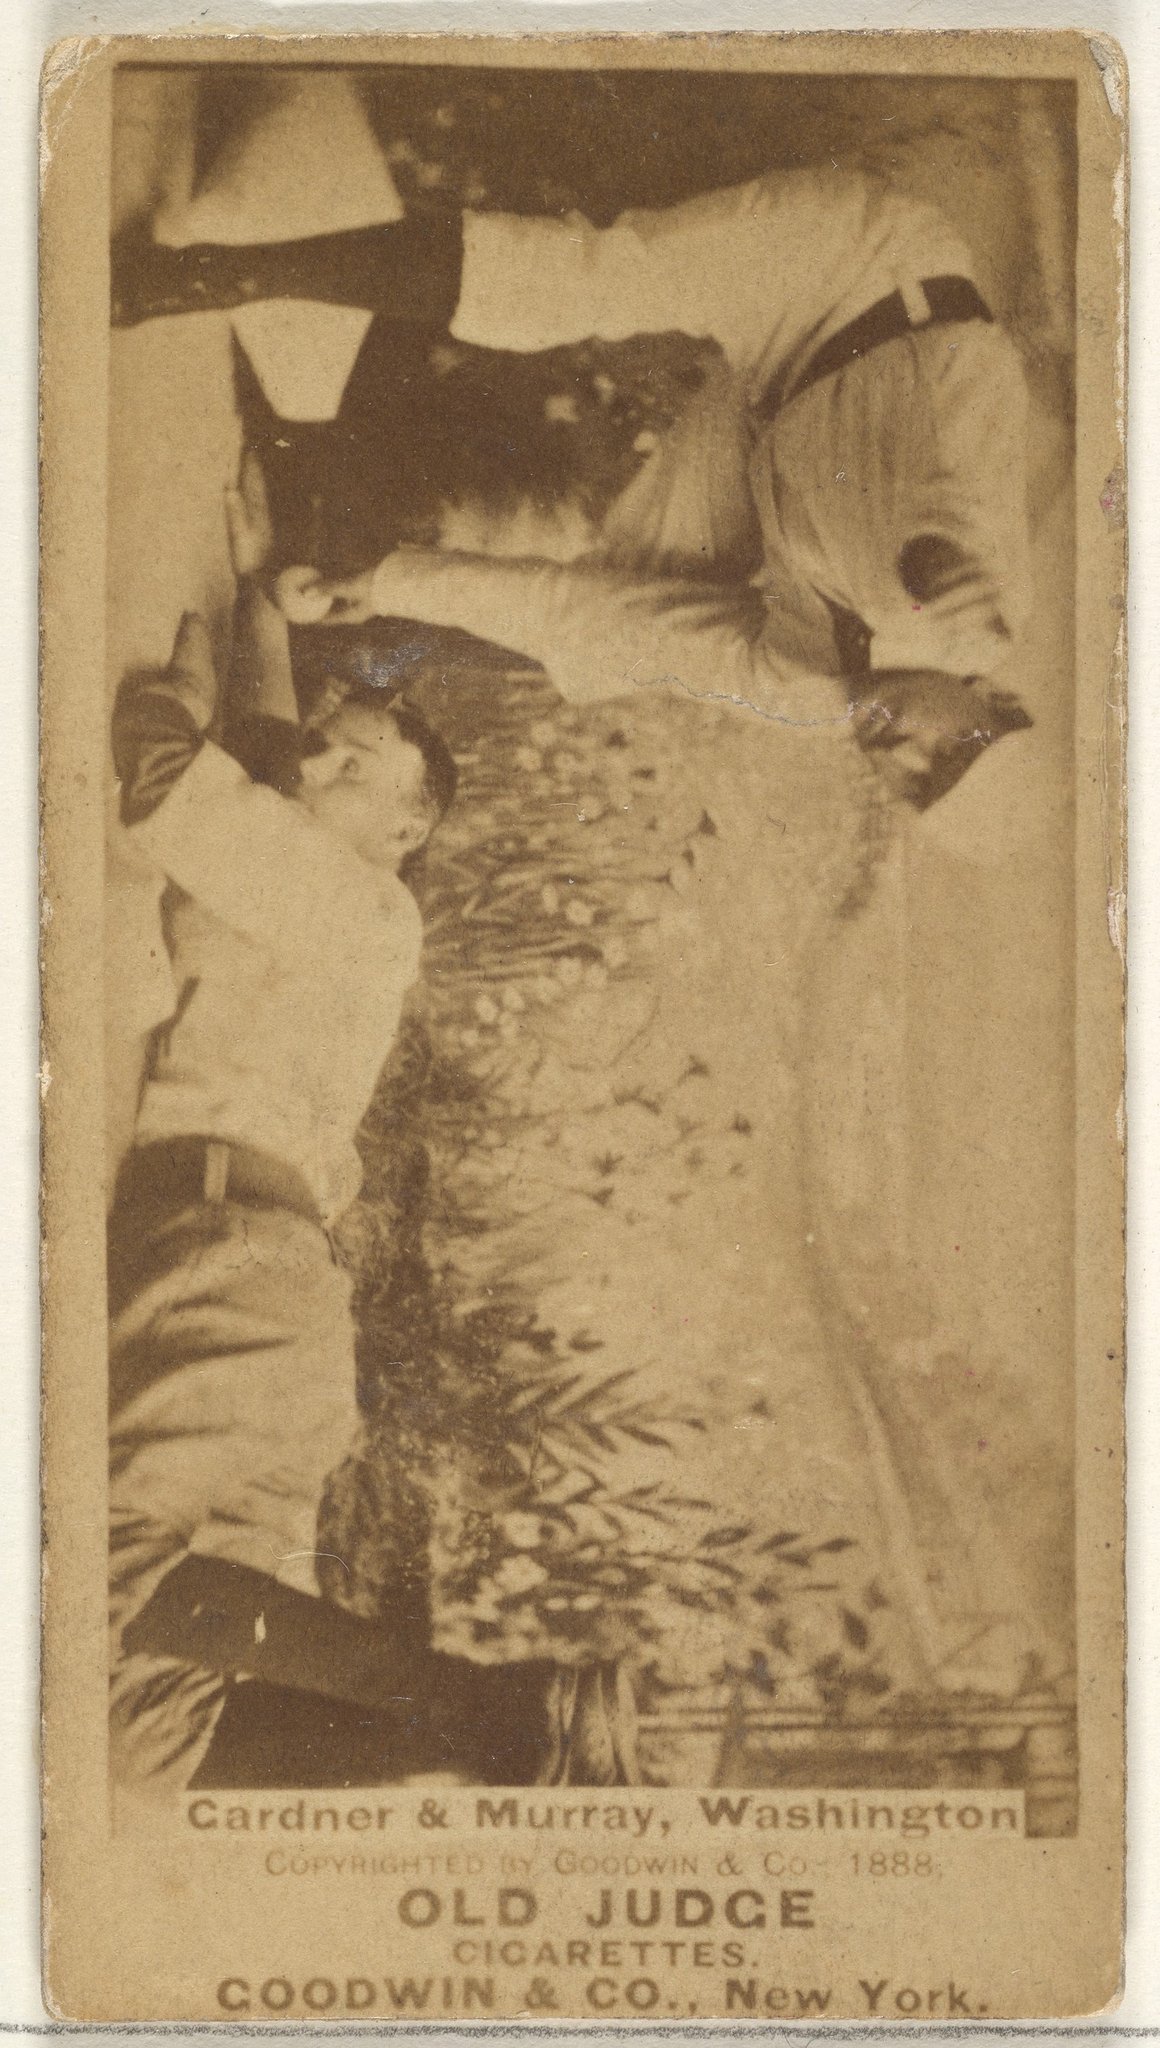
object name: baseball card, photograph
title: Franklin Washington "Gid" Gardner and Jeremiah J. "Miah" Murray, Washington Nationals, from the Old Judge series (N172) for Old Judge Cigarettes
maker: goodwin & company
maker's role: publisher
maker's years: 1850-1950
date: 1888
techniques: albumen silver print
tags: men,portraits,baseball,athletes